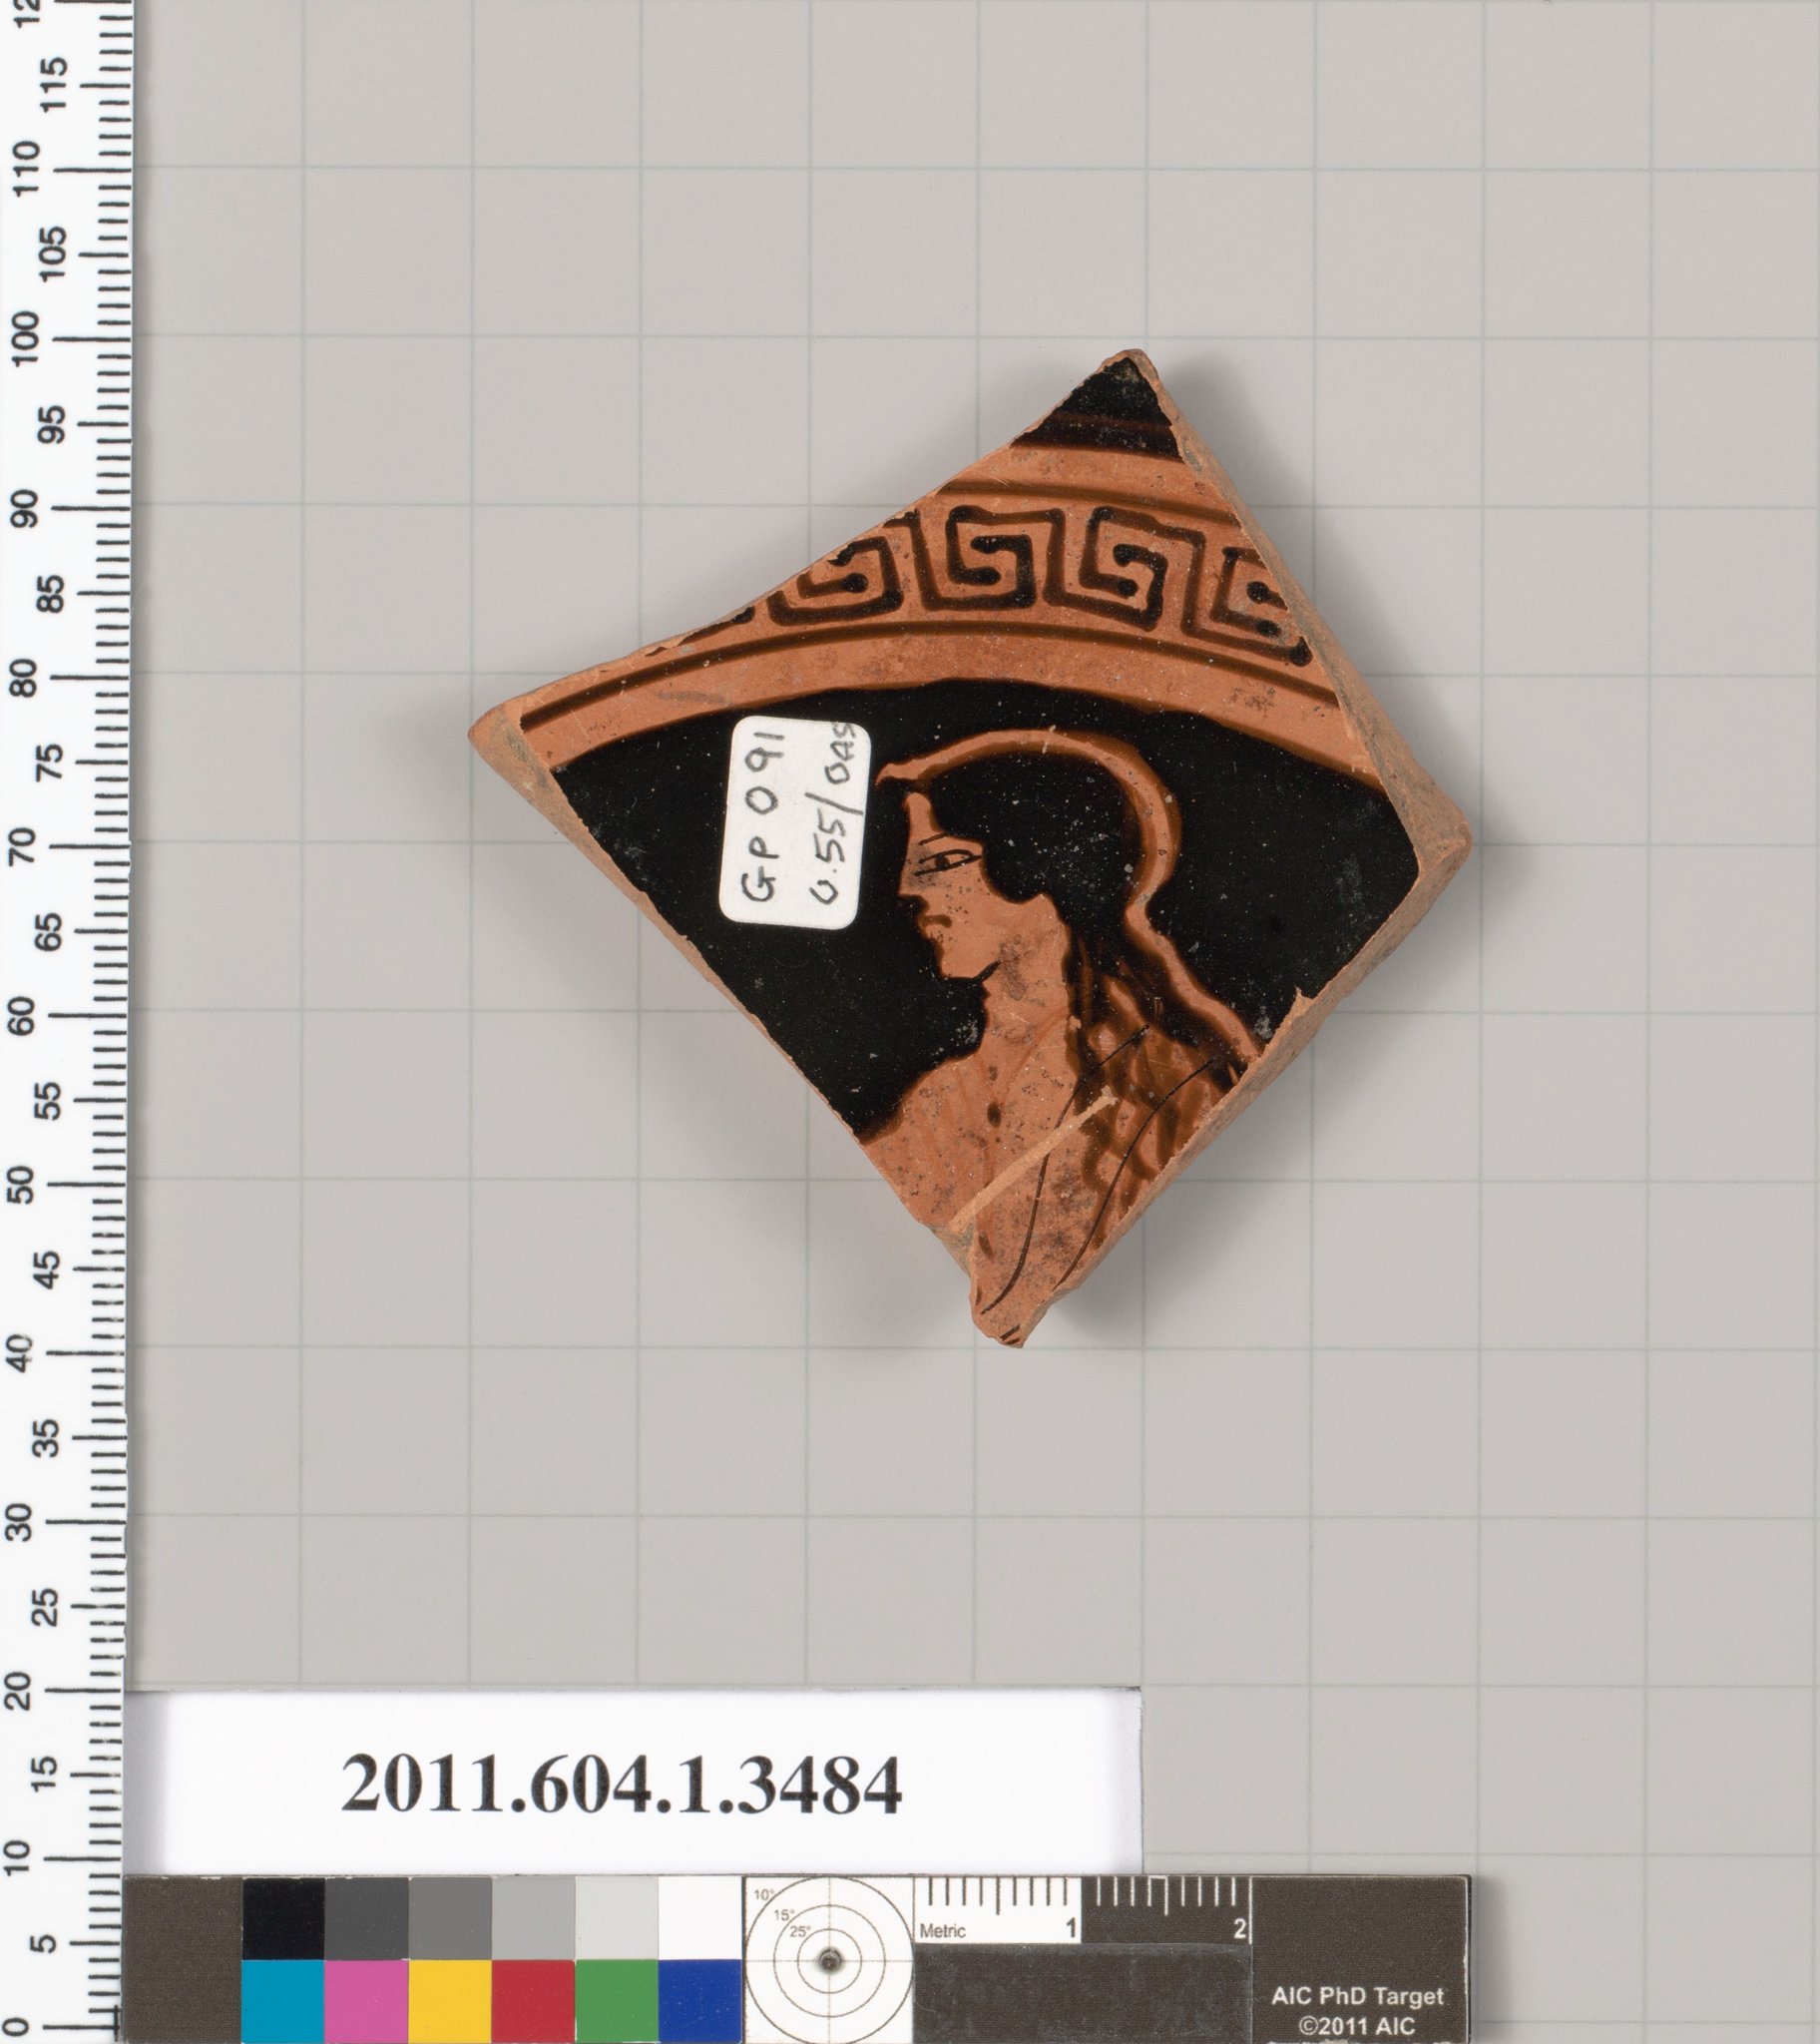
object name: kylix fragment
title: Terracotta fragment of a kylix (drinking cup)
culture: greek, attic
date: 470-460 BCE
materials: terracotta